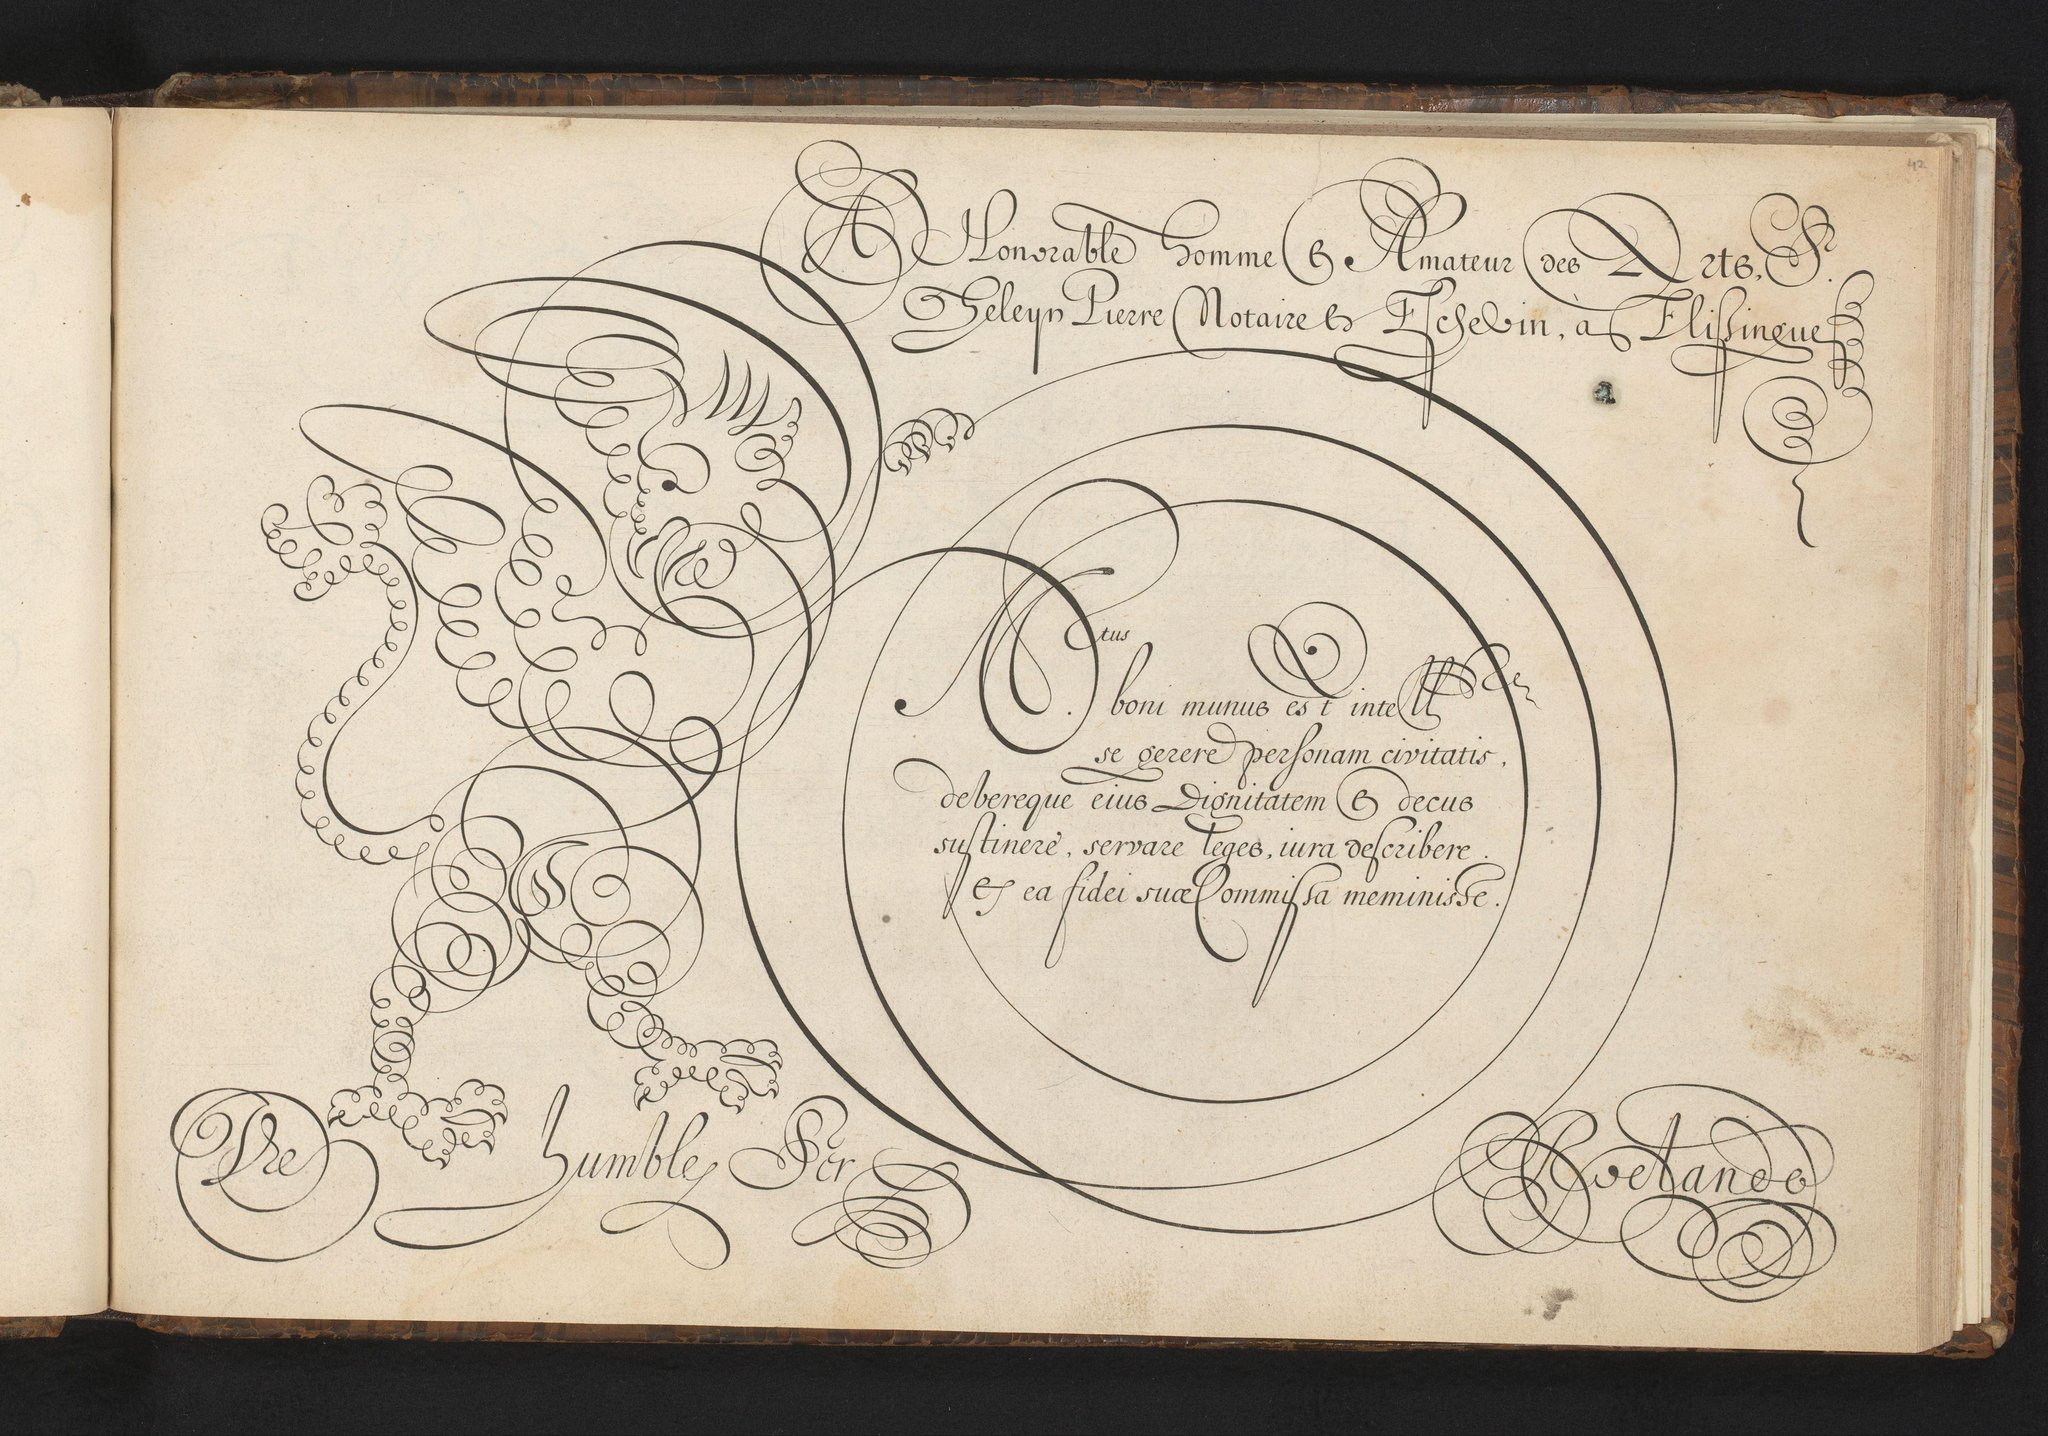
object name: album leaf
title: Schrijfvoorbeeld met een griffioen in krulwerk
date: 1616-1617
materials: paper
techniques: engraving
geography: flushing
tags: calligraphy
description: Schrijfvoorbeeld met vijf regels tekst in het Latijn: Mtus boni munus est ... Daarboven in het Frans een opdracht aan Geleyn Pieters, schepen te Vlissingen. Links een griffioen in krulwerk. De prent maakt deel uit van een album.